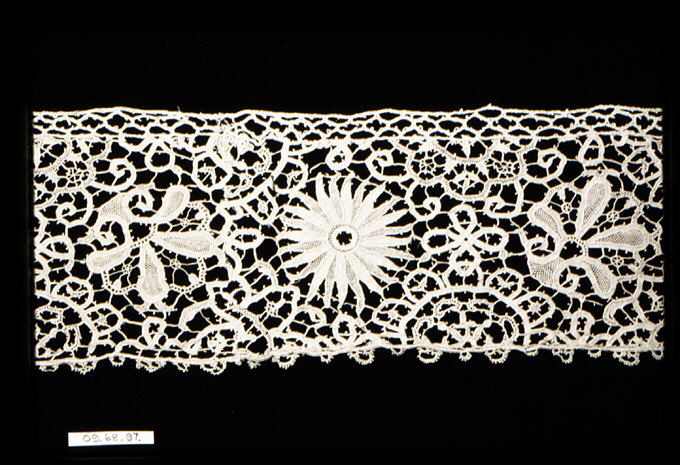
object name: border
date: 1501-1700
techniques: lace